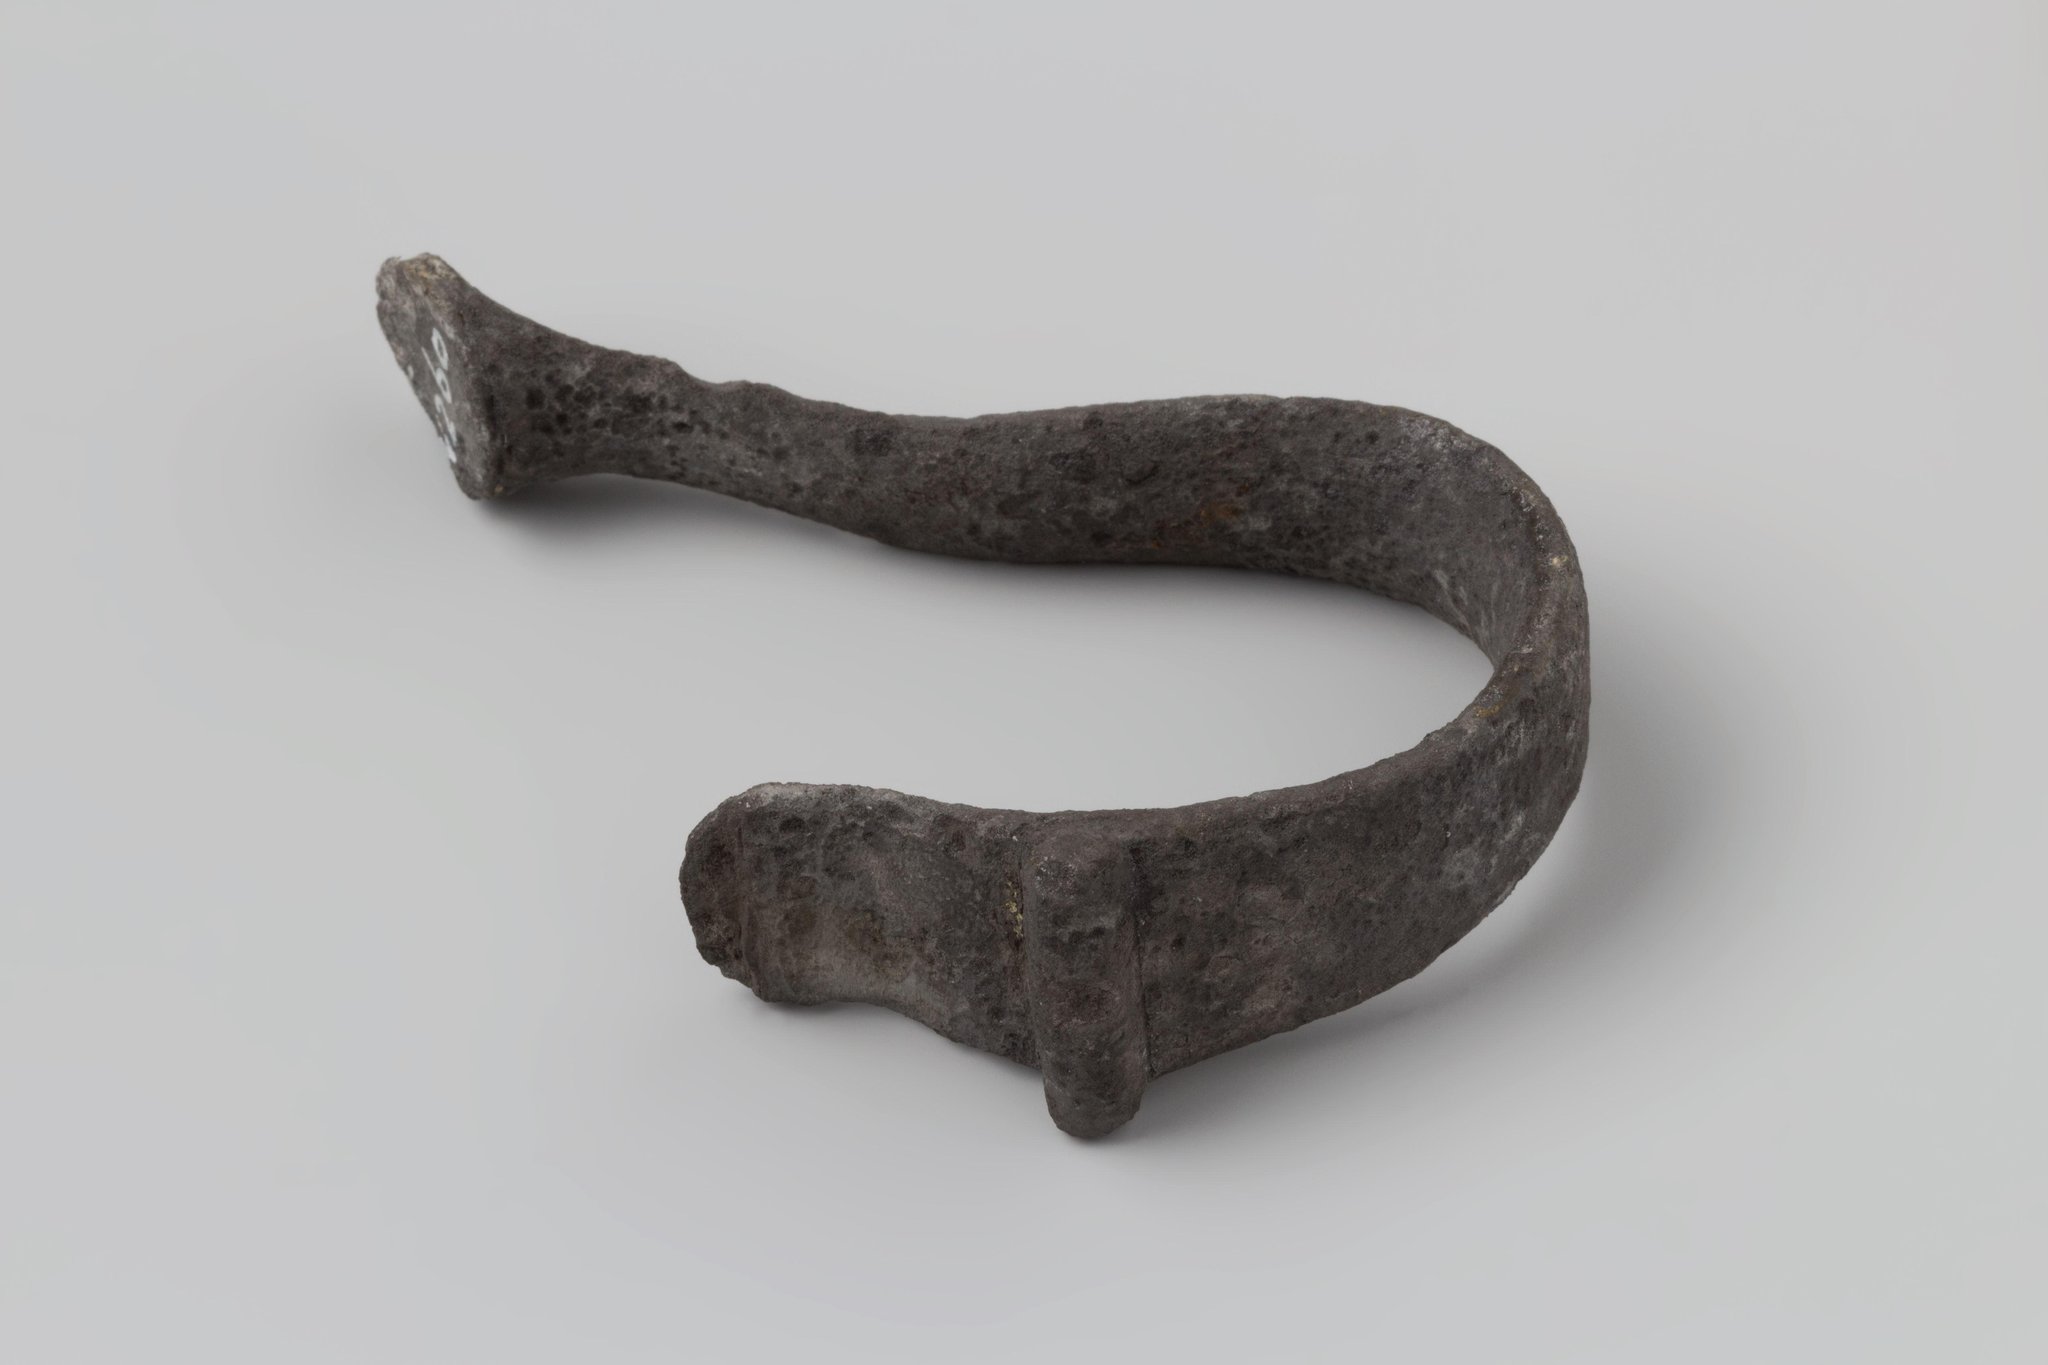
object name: handle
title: Handvat van tin uit het wrak van de in 1735 vergane Oost-Indiëvaarder 't Vliegend Hart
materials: tin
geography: middelburg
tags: 't vliegend hart (schip), verenigde oostindische compagnie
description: Onversierd zwart-grijs gebogen handvat dat zich aan de uiteinden verbreed.